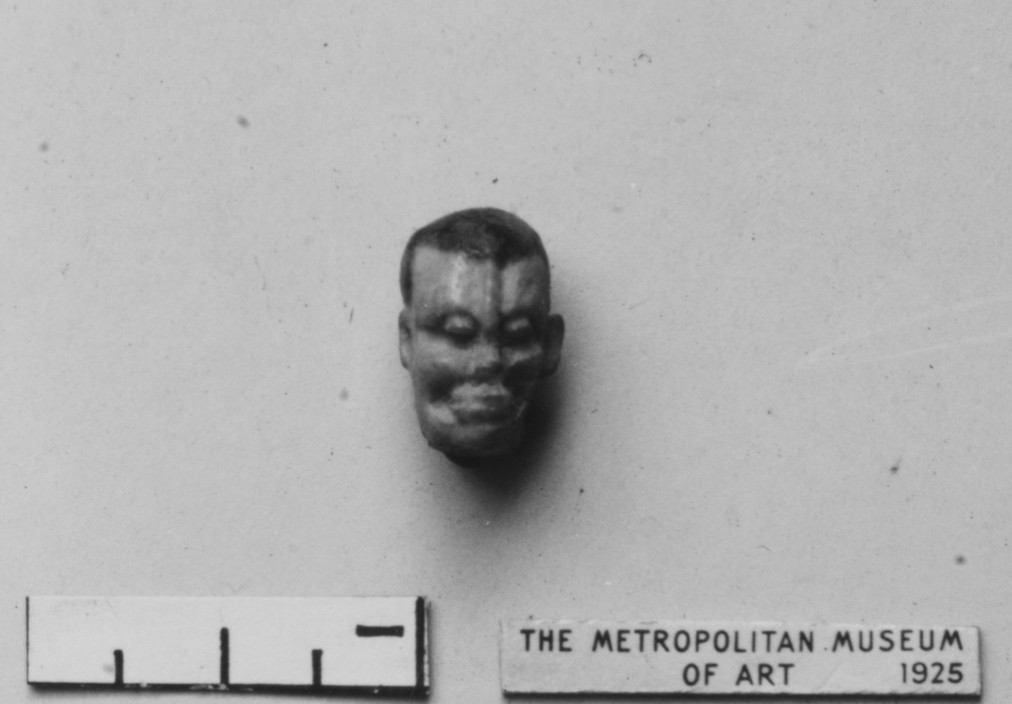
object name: amulet, black african head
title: Head Amulet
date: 664-332 BCE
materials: faience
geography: egypt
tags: heads